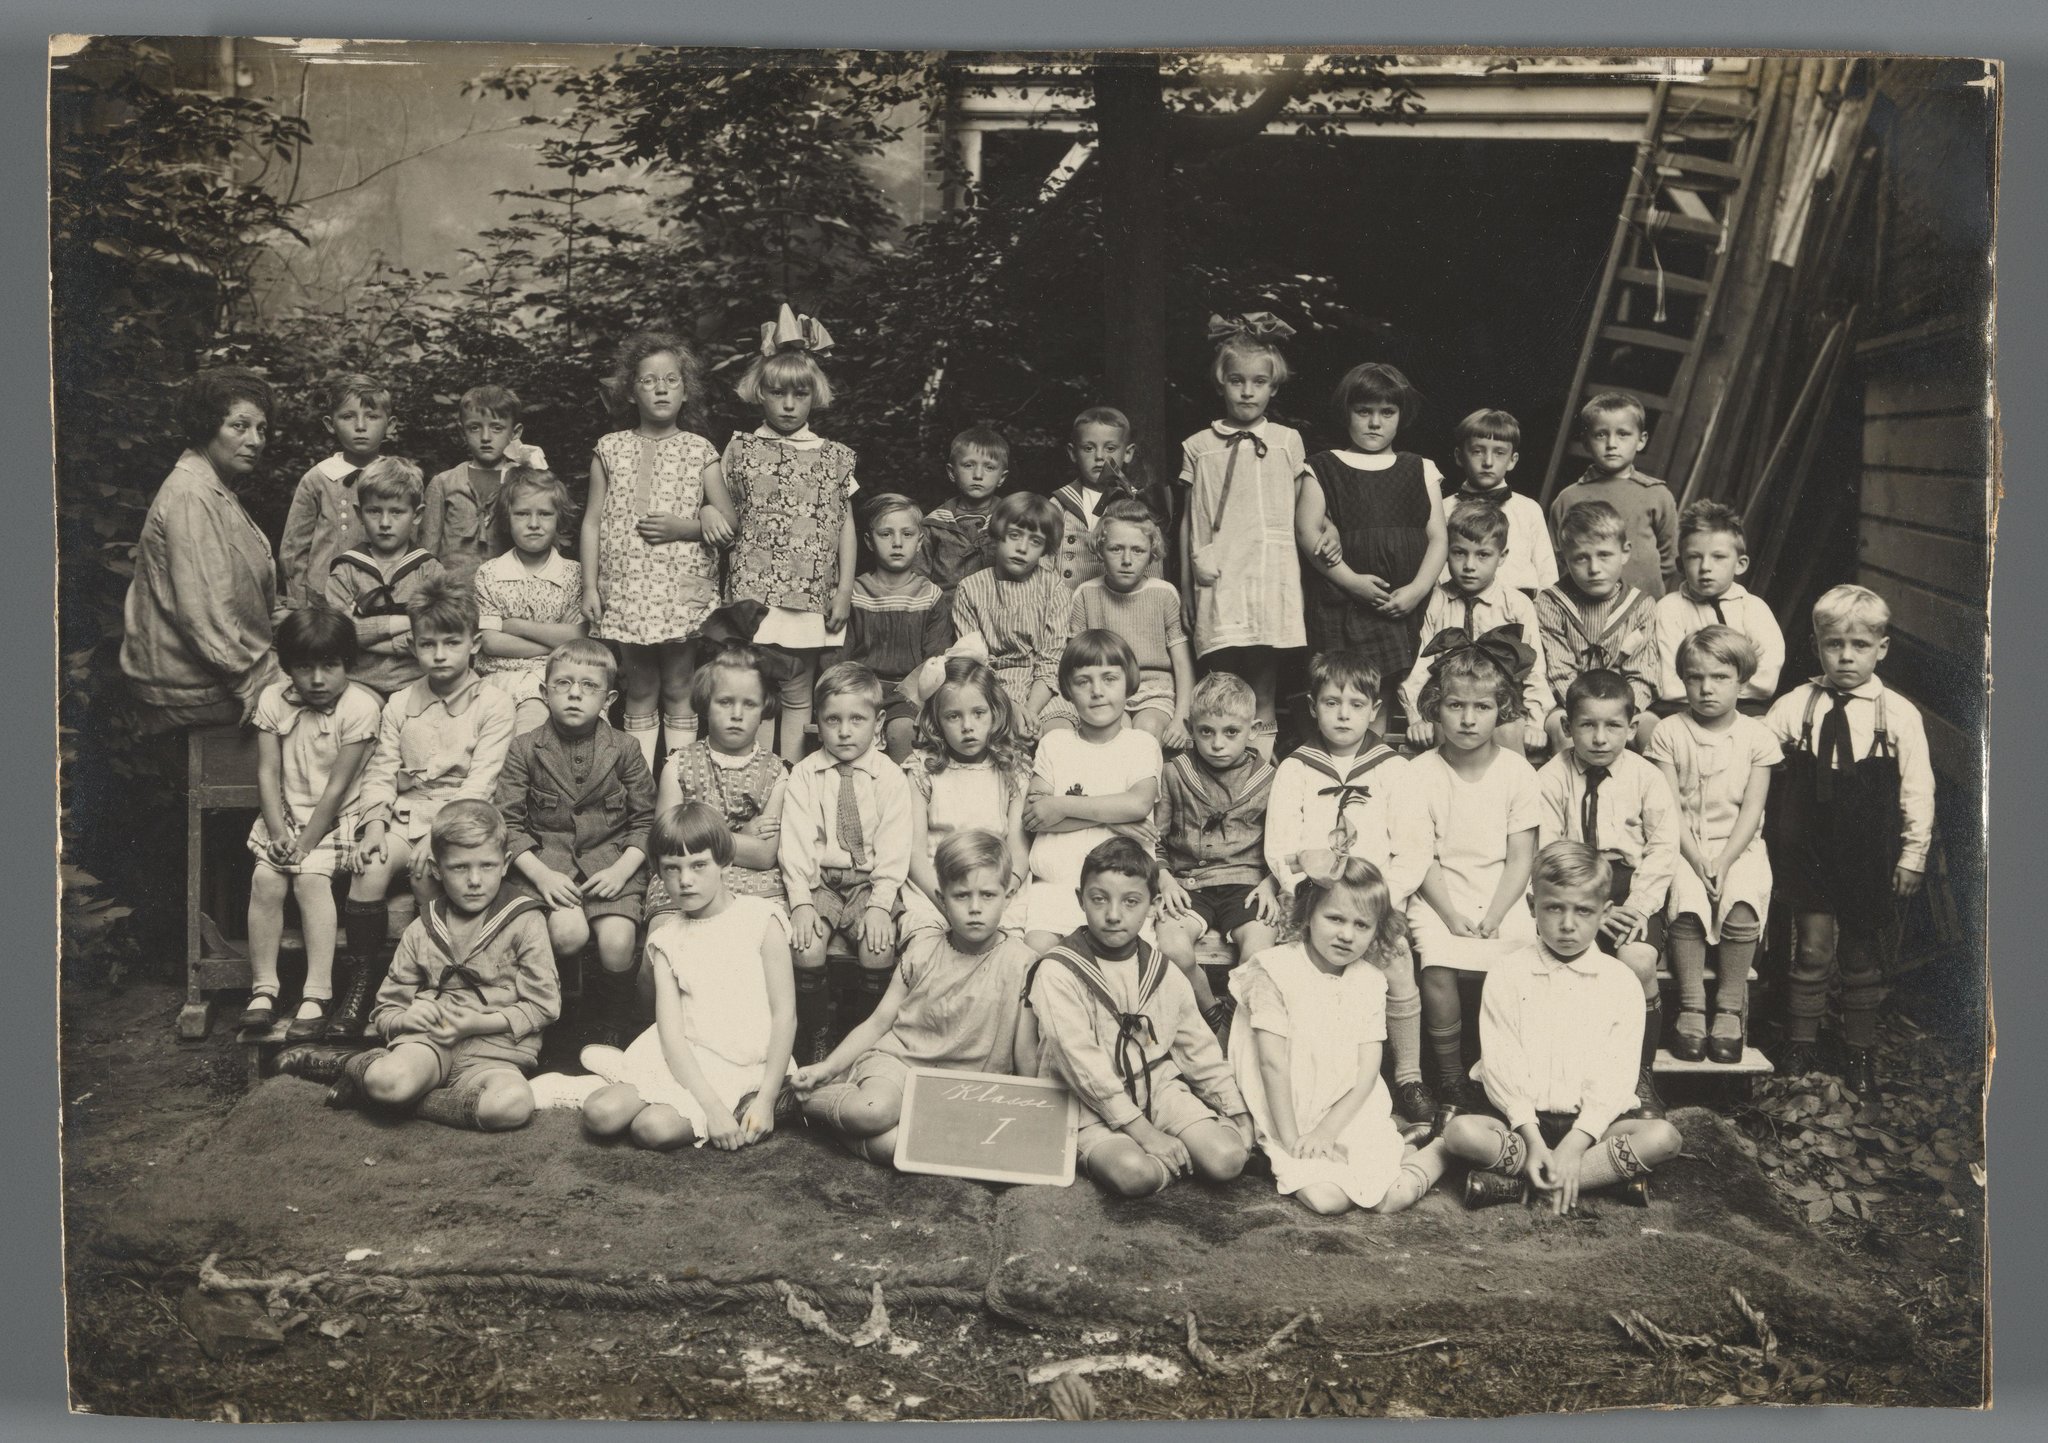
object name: photograph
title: Groepsportret van een onbekende schoolklas met jongens en meisjes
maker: Anonymous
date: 1920-1930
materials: paper, cardboard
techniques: gelatin silver print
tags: elementary school; class, form, anonymous historical persons portrayed in a group, in a group-portrait